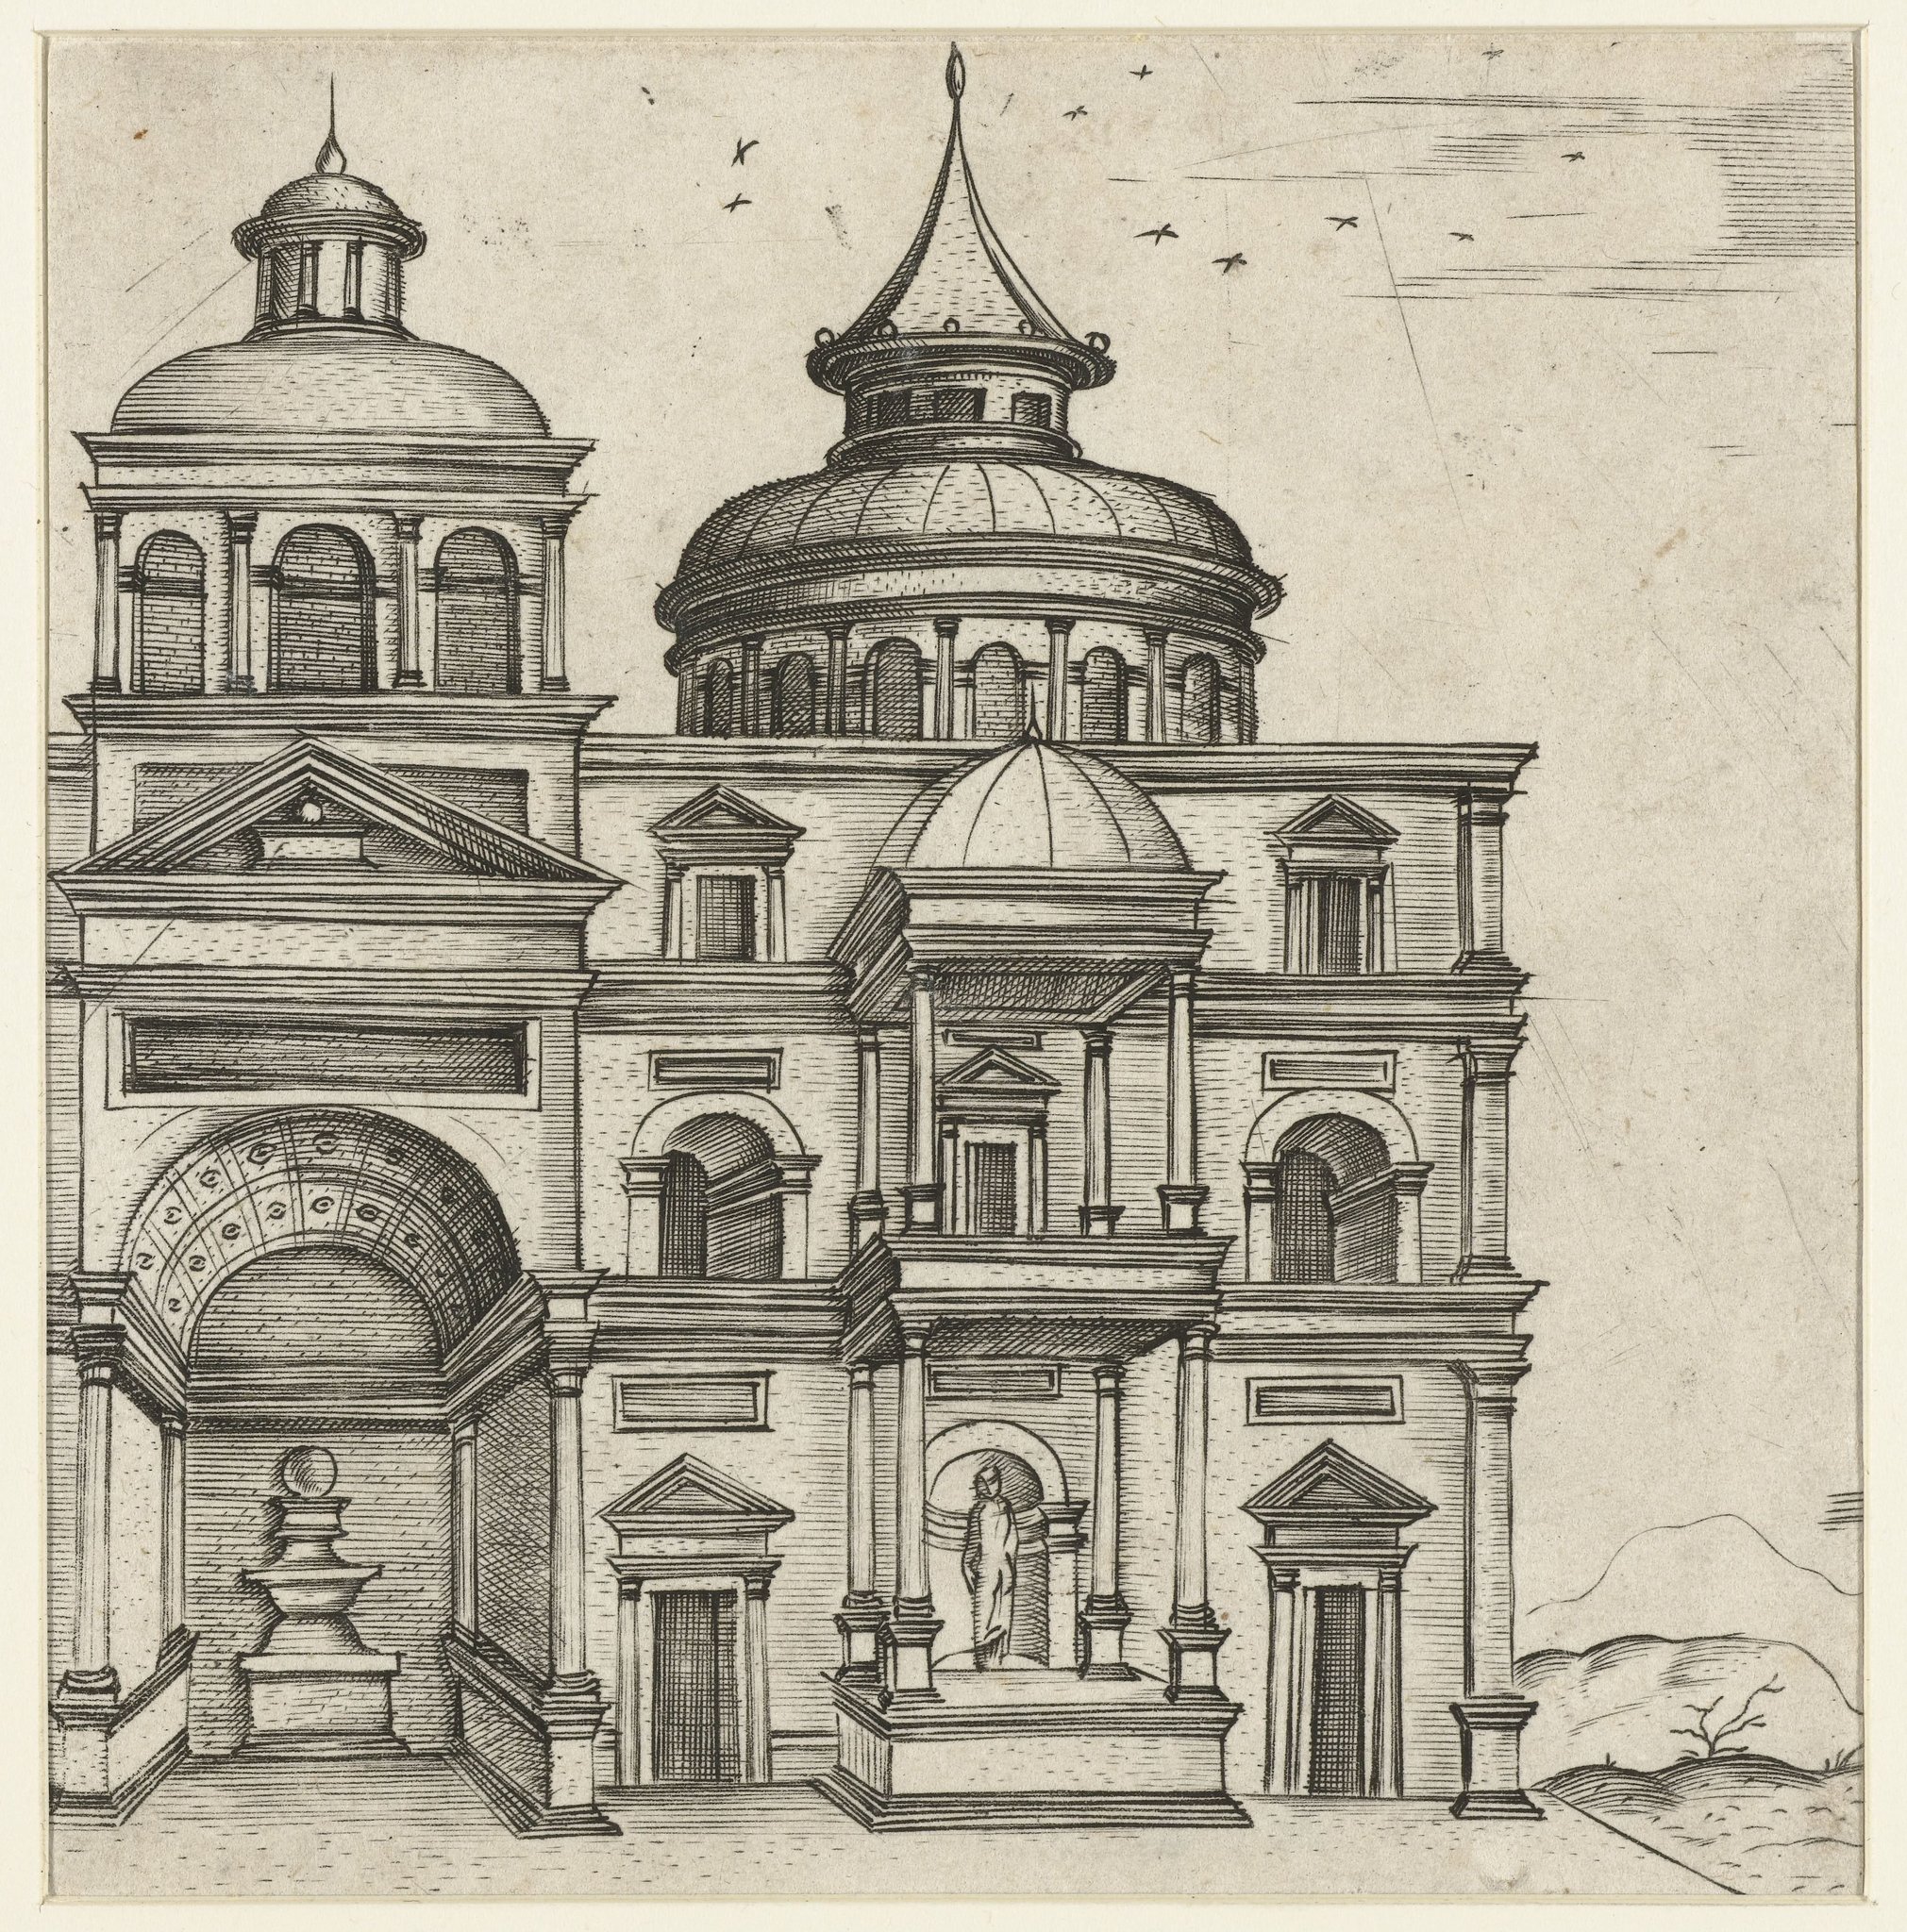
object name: print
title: Deel van het exterieur van een klassiek paleis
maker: Anonymous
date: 1500-1549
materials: paper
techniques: engraving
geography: italy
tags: palace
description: Deel van het exterieur van een klassiek paleis: twee ronde koepels op een gebouw met twee verdiepingen. Deze prent is onderdeel van een serie prenten van antieke gebouwen.